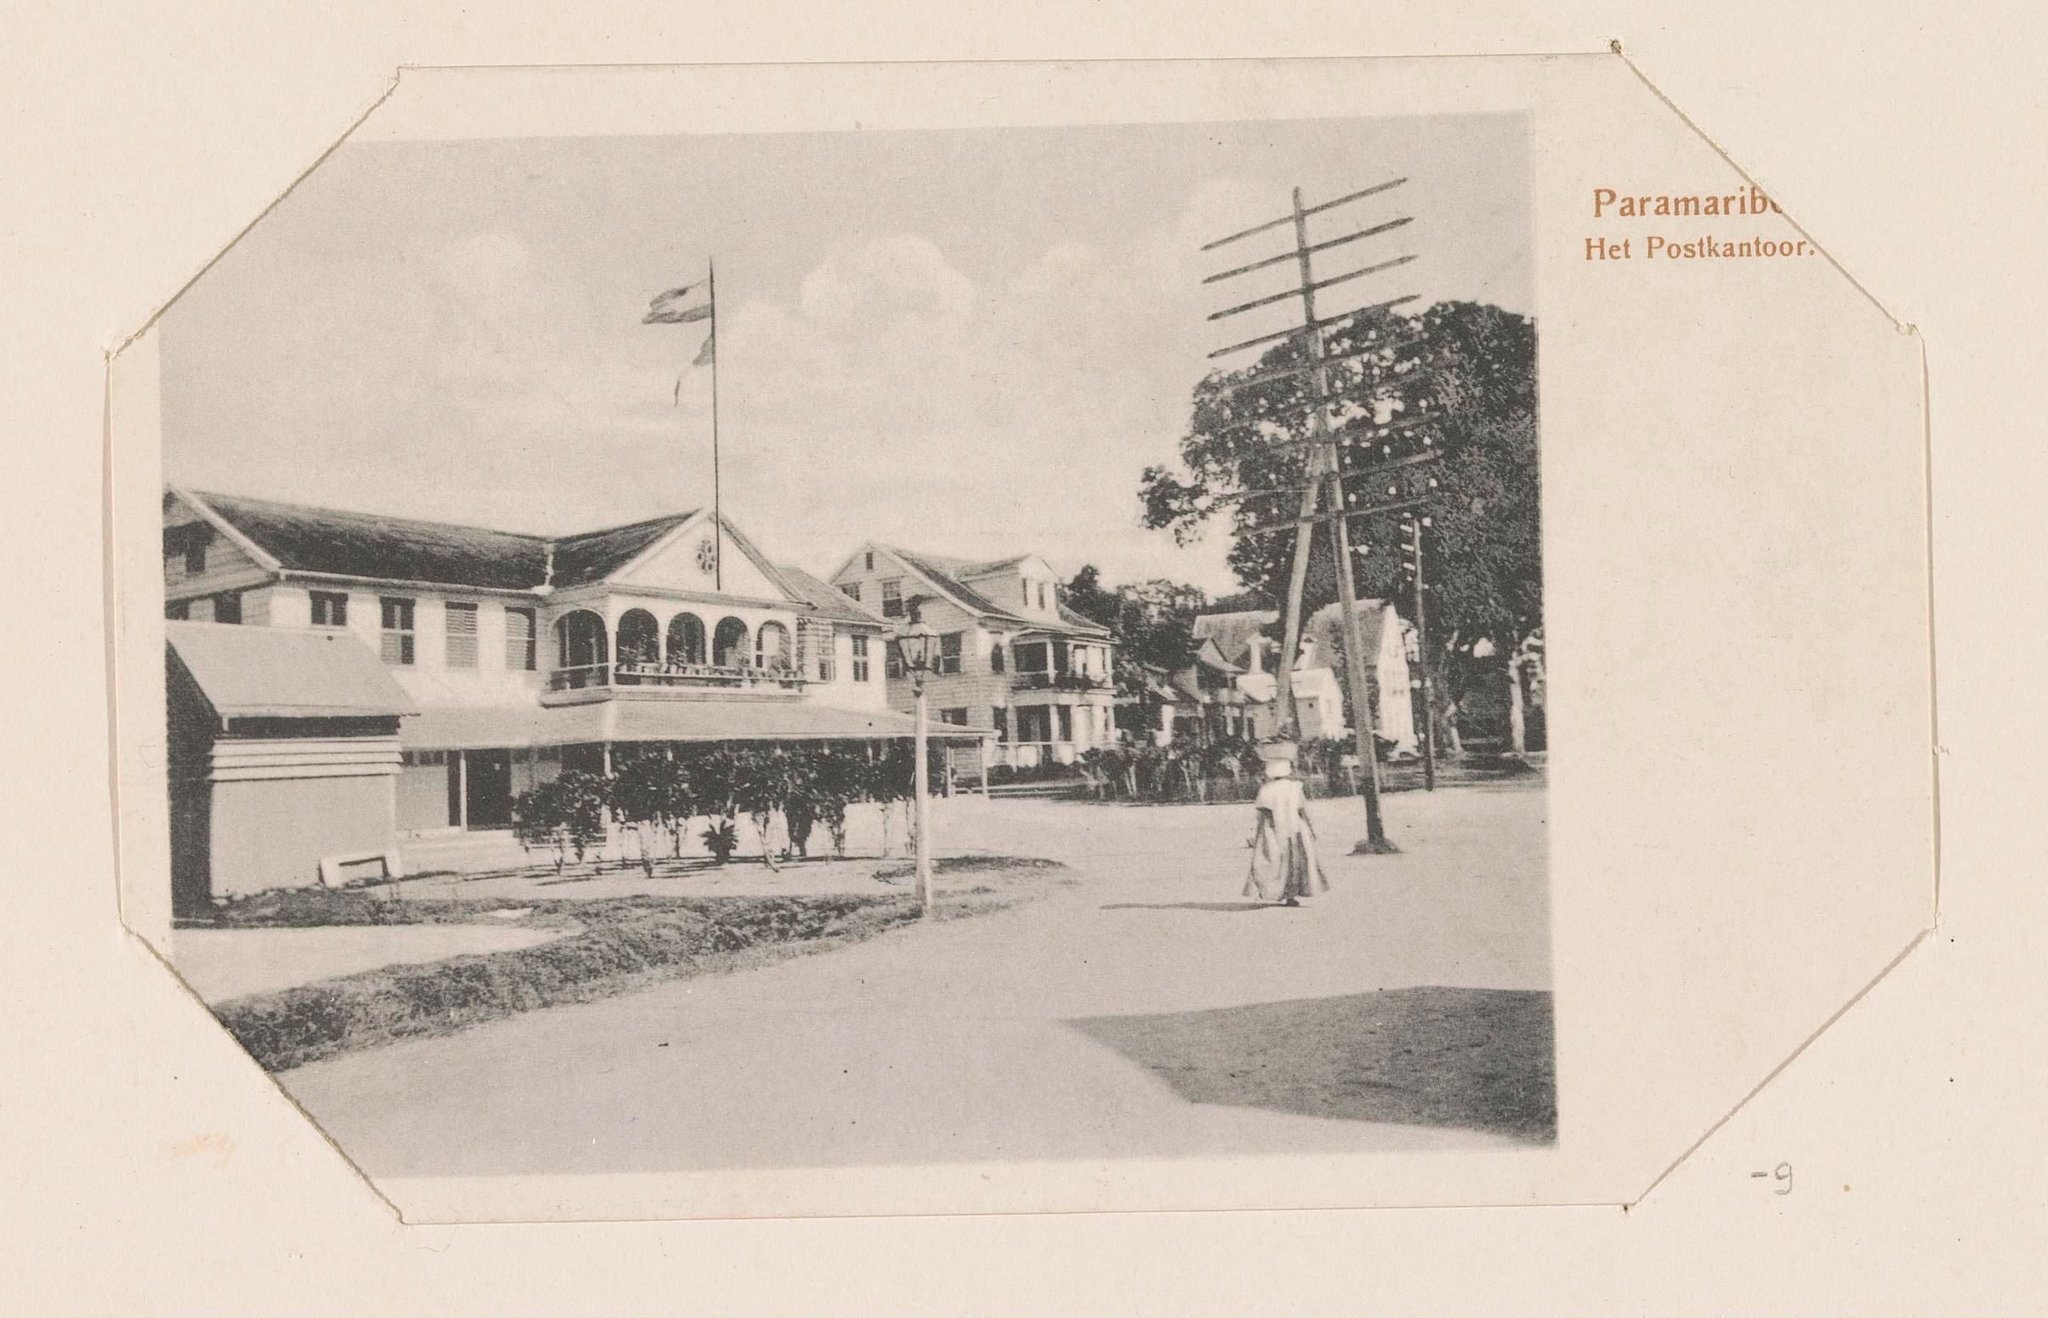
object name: ansichtkaart, prentbriefkaart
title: Paramaribo Het Postkantoor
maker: eugen klein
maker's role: fotograaf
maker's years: 1869-1927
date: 1900-1910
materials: cardboard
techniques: photograph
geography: paramaribo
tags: post-office, suriname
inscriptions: serial number: ‘Eigendom van Eugen Klein, Paramaribo No. 17’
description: Het Postkantoor te Paramaribo. Onderdeel van een verzameling van 68 briefkaarten uit Suriname, bijeengebracht in een album als aandenken aan een verblijf in Suriname in september 1911.